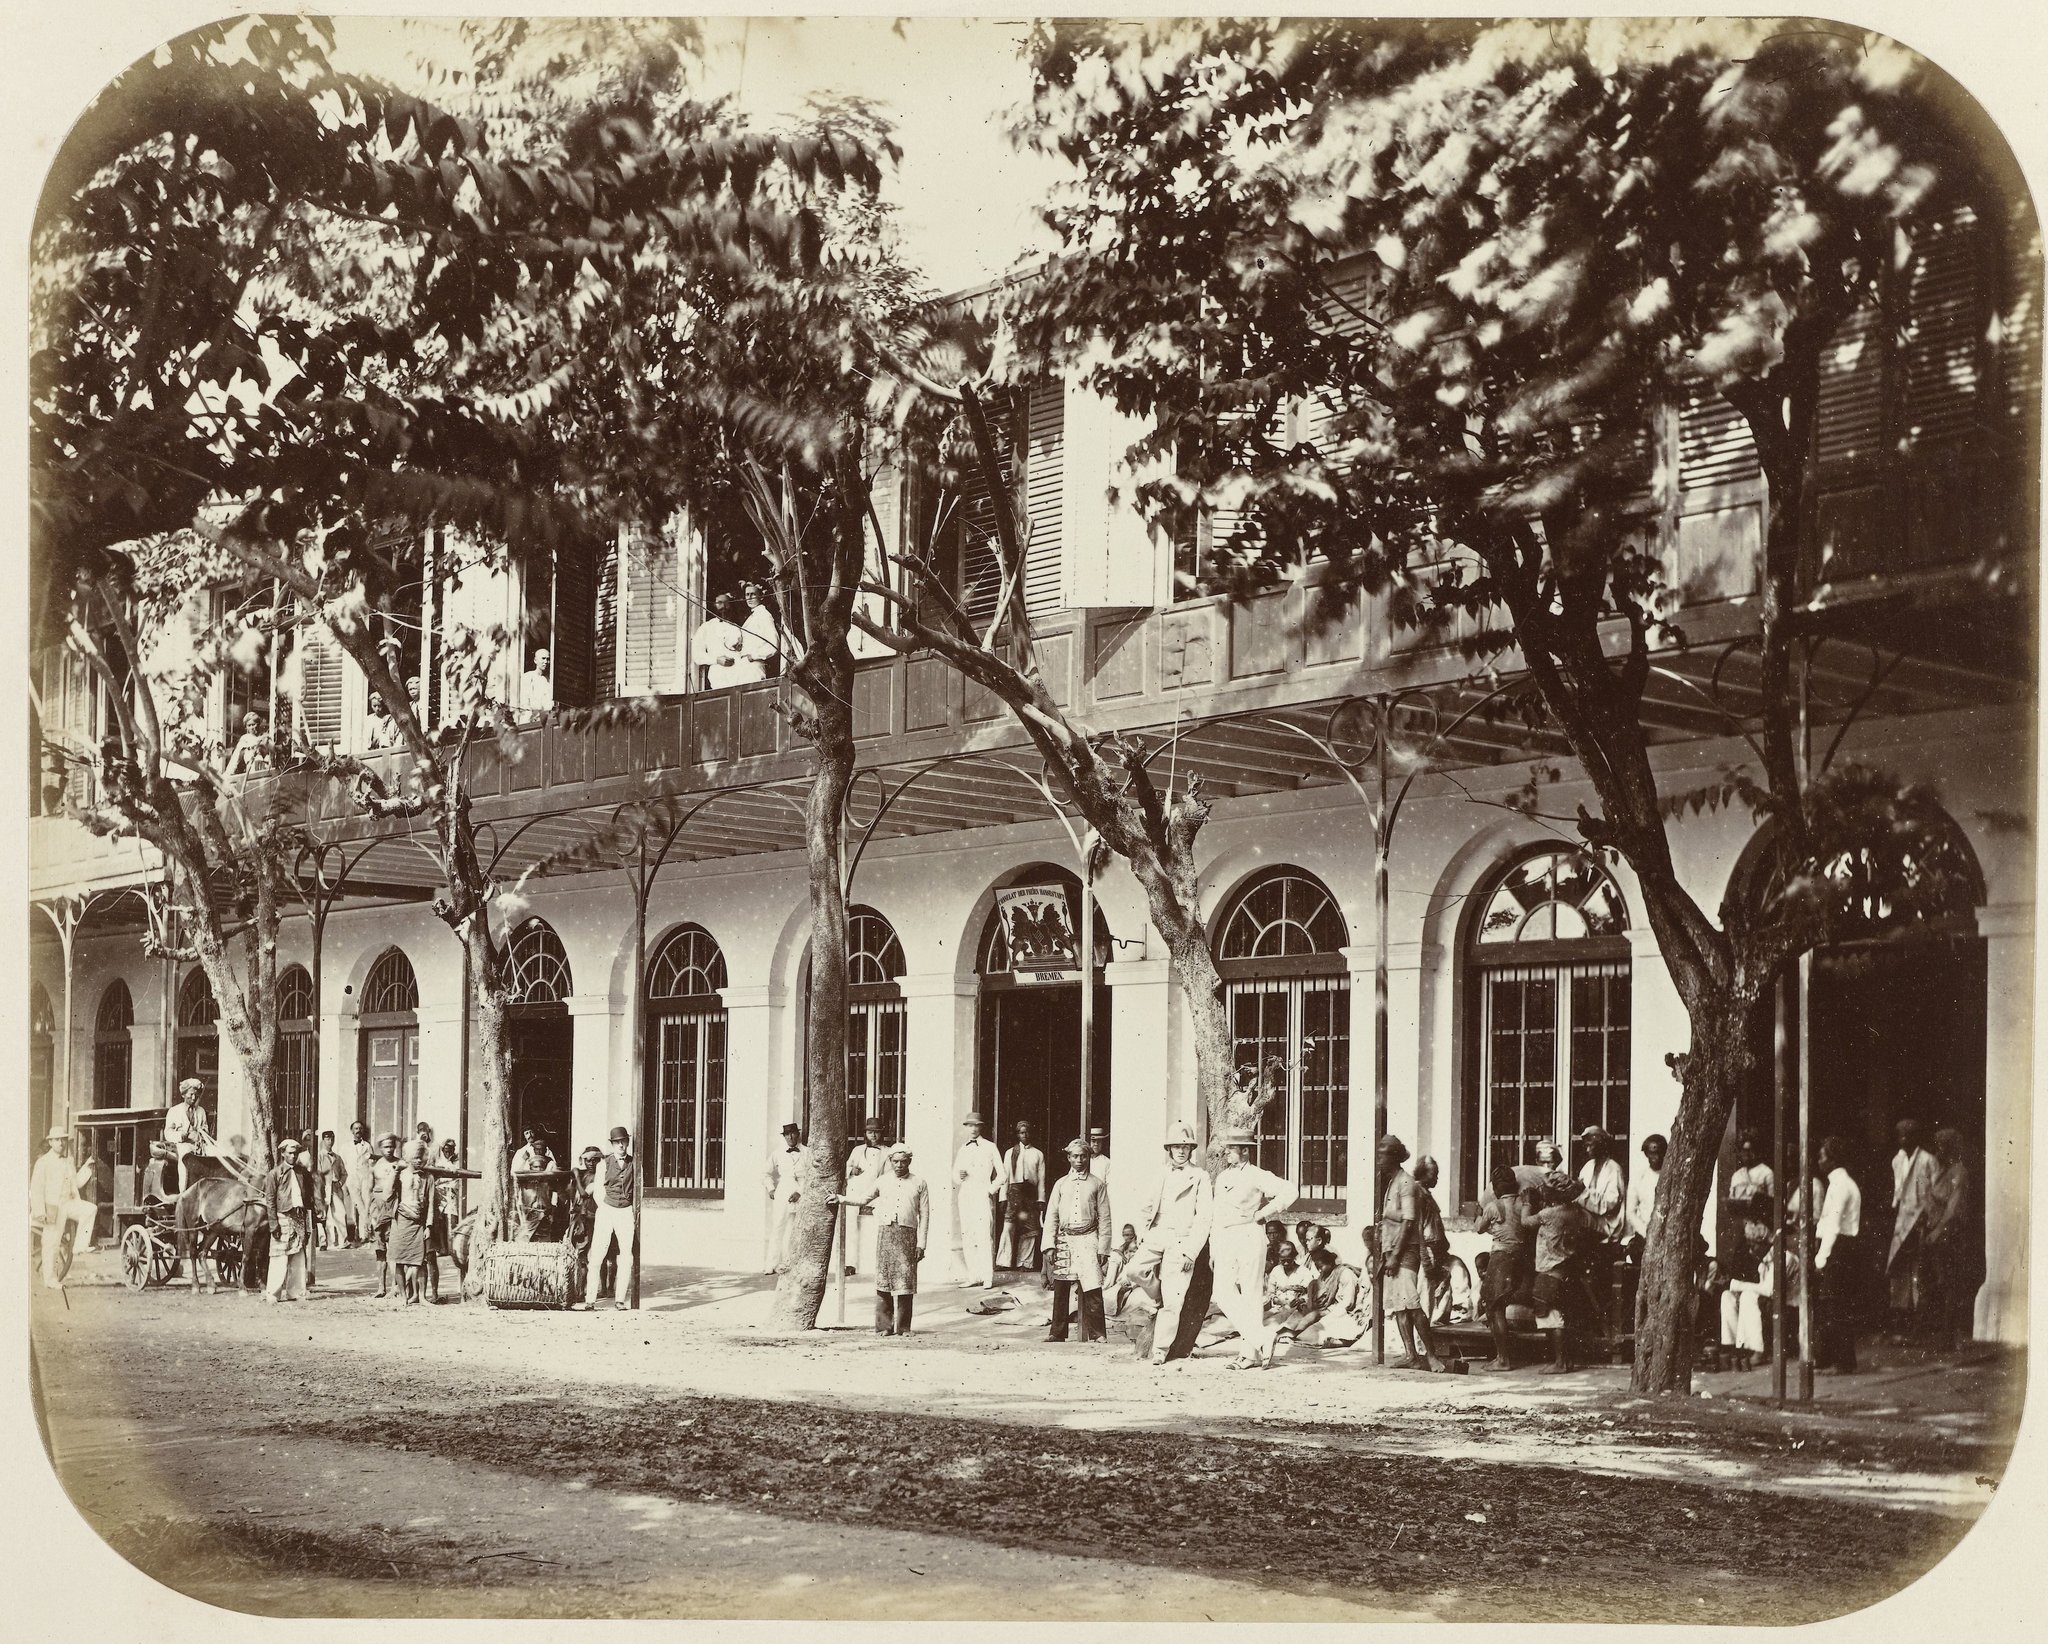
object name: photograph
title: Handelshuizen aan de Kali Besar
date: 1865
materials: photographic support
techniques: albumen print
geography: batavia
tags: large-scale structure for storage, e.g.: warehouse, depot, silo, locations for trading, public road, merchant, salesman, java, batavia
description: Handelshuizen aan de Kali Besar te Batavia met het consulaat van de stad Bremen. Voor de huizen poseren Europeanen en Indiërs, links een baal met het logo B&K van de Duitse firma C. Bahre & G. Kinder. Ingeplakte foto in het fotoalbum getiteld: Gezichten van Java.